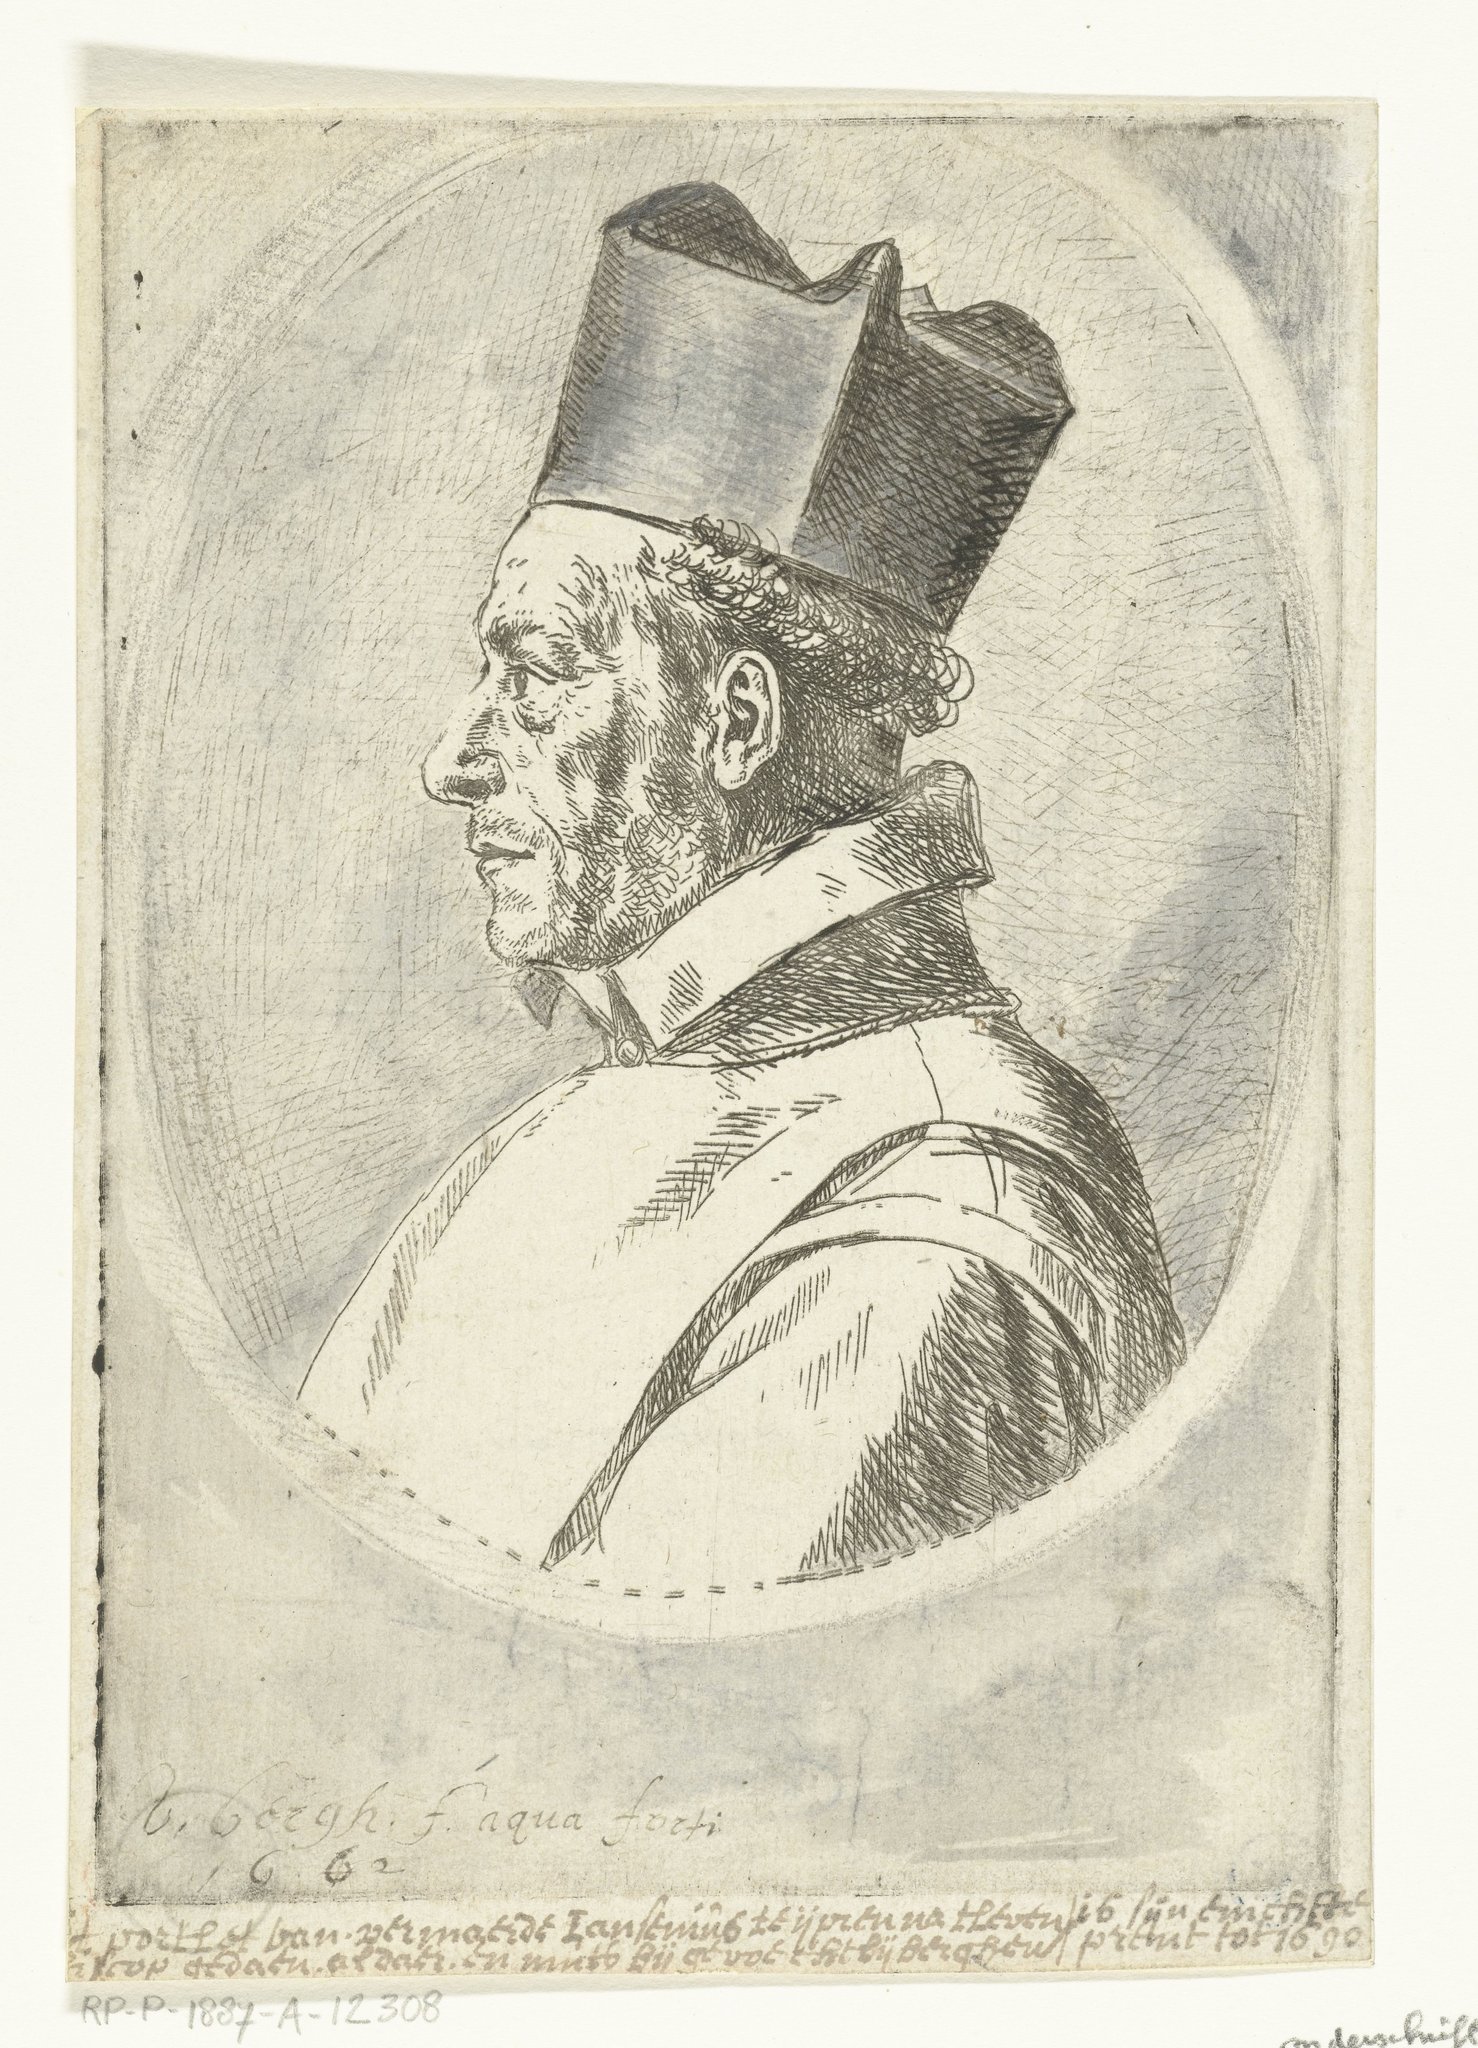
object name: print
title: Portret van Cornelius Jansenius, bisschop van Ieper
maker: matthys van den bergh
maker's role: draughtsman, print maker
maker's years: 1617-1687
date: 1662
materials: paper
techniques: brush, etching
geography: netherlands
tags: louvain, archbishop, bishop, etc. (roman catholic)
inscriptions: collector's mark: Lugt 514, collector's mark, inscription: ‘t' portret van vermaerde Iansenius te Ypren na tleven/ ijcop gedaen aldaer en muts bij gevoecht bij Berghensprent/ Is zijn einichste/ prent tot 1690’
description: Portret van Cornelius Jansenius, bisschop van Ieper en profil, met vierkante baret en gekleed in stola.